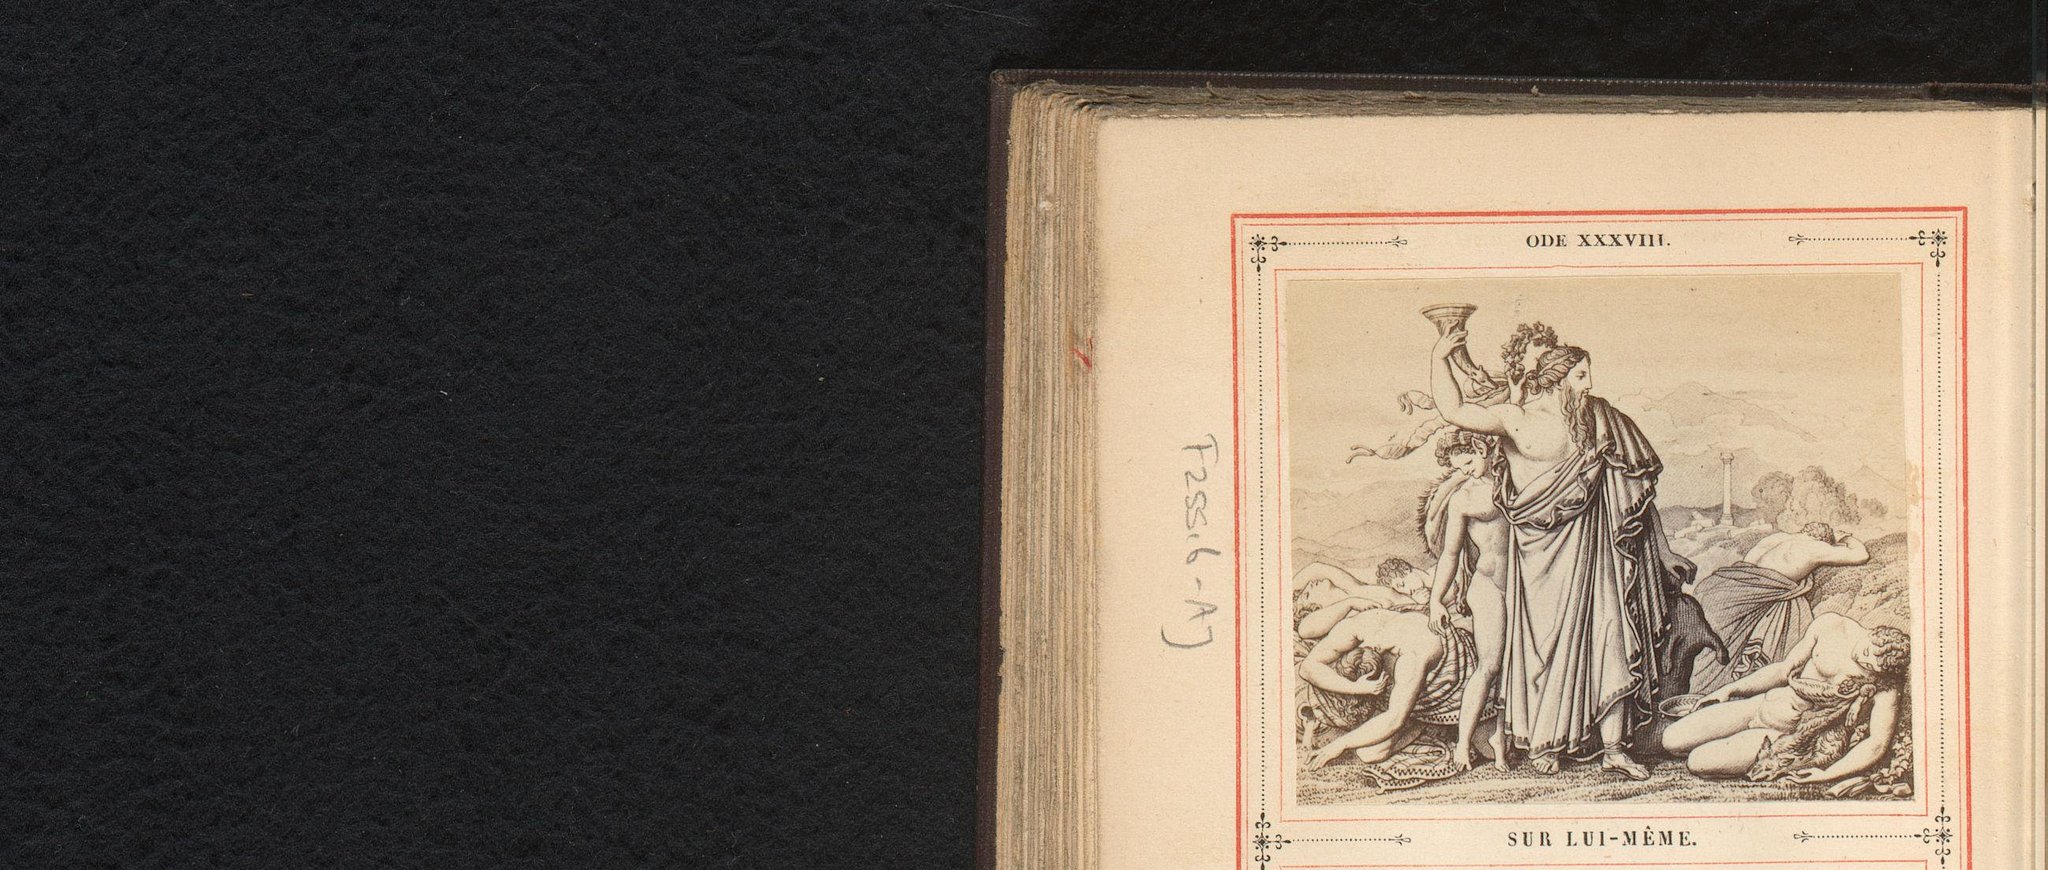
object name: reproduction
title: Sur lui-même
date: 1859-1864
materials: paper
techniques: albumen print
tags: gods ~ classical mythology